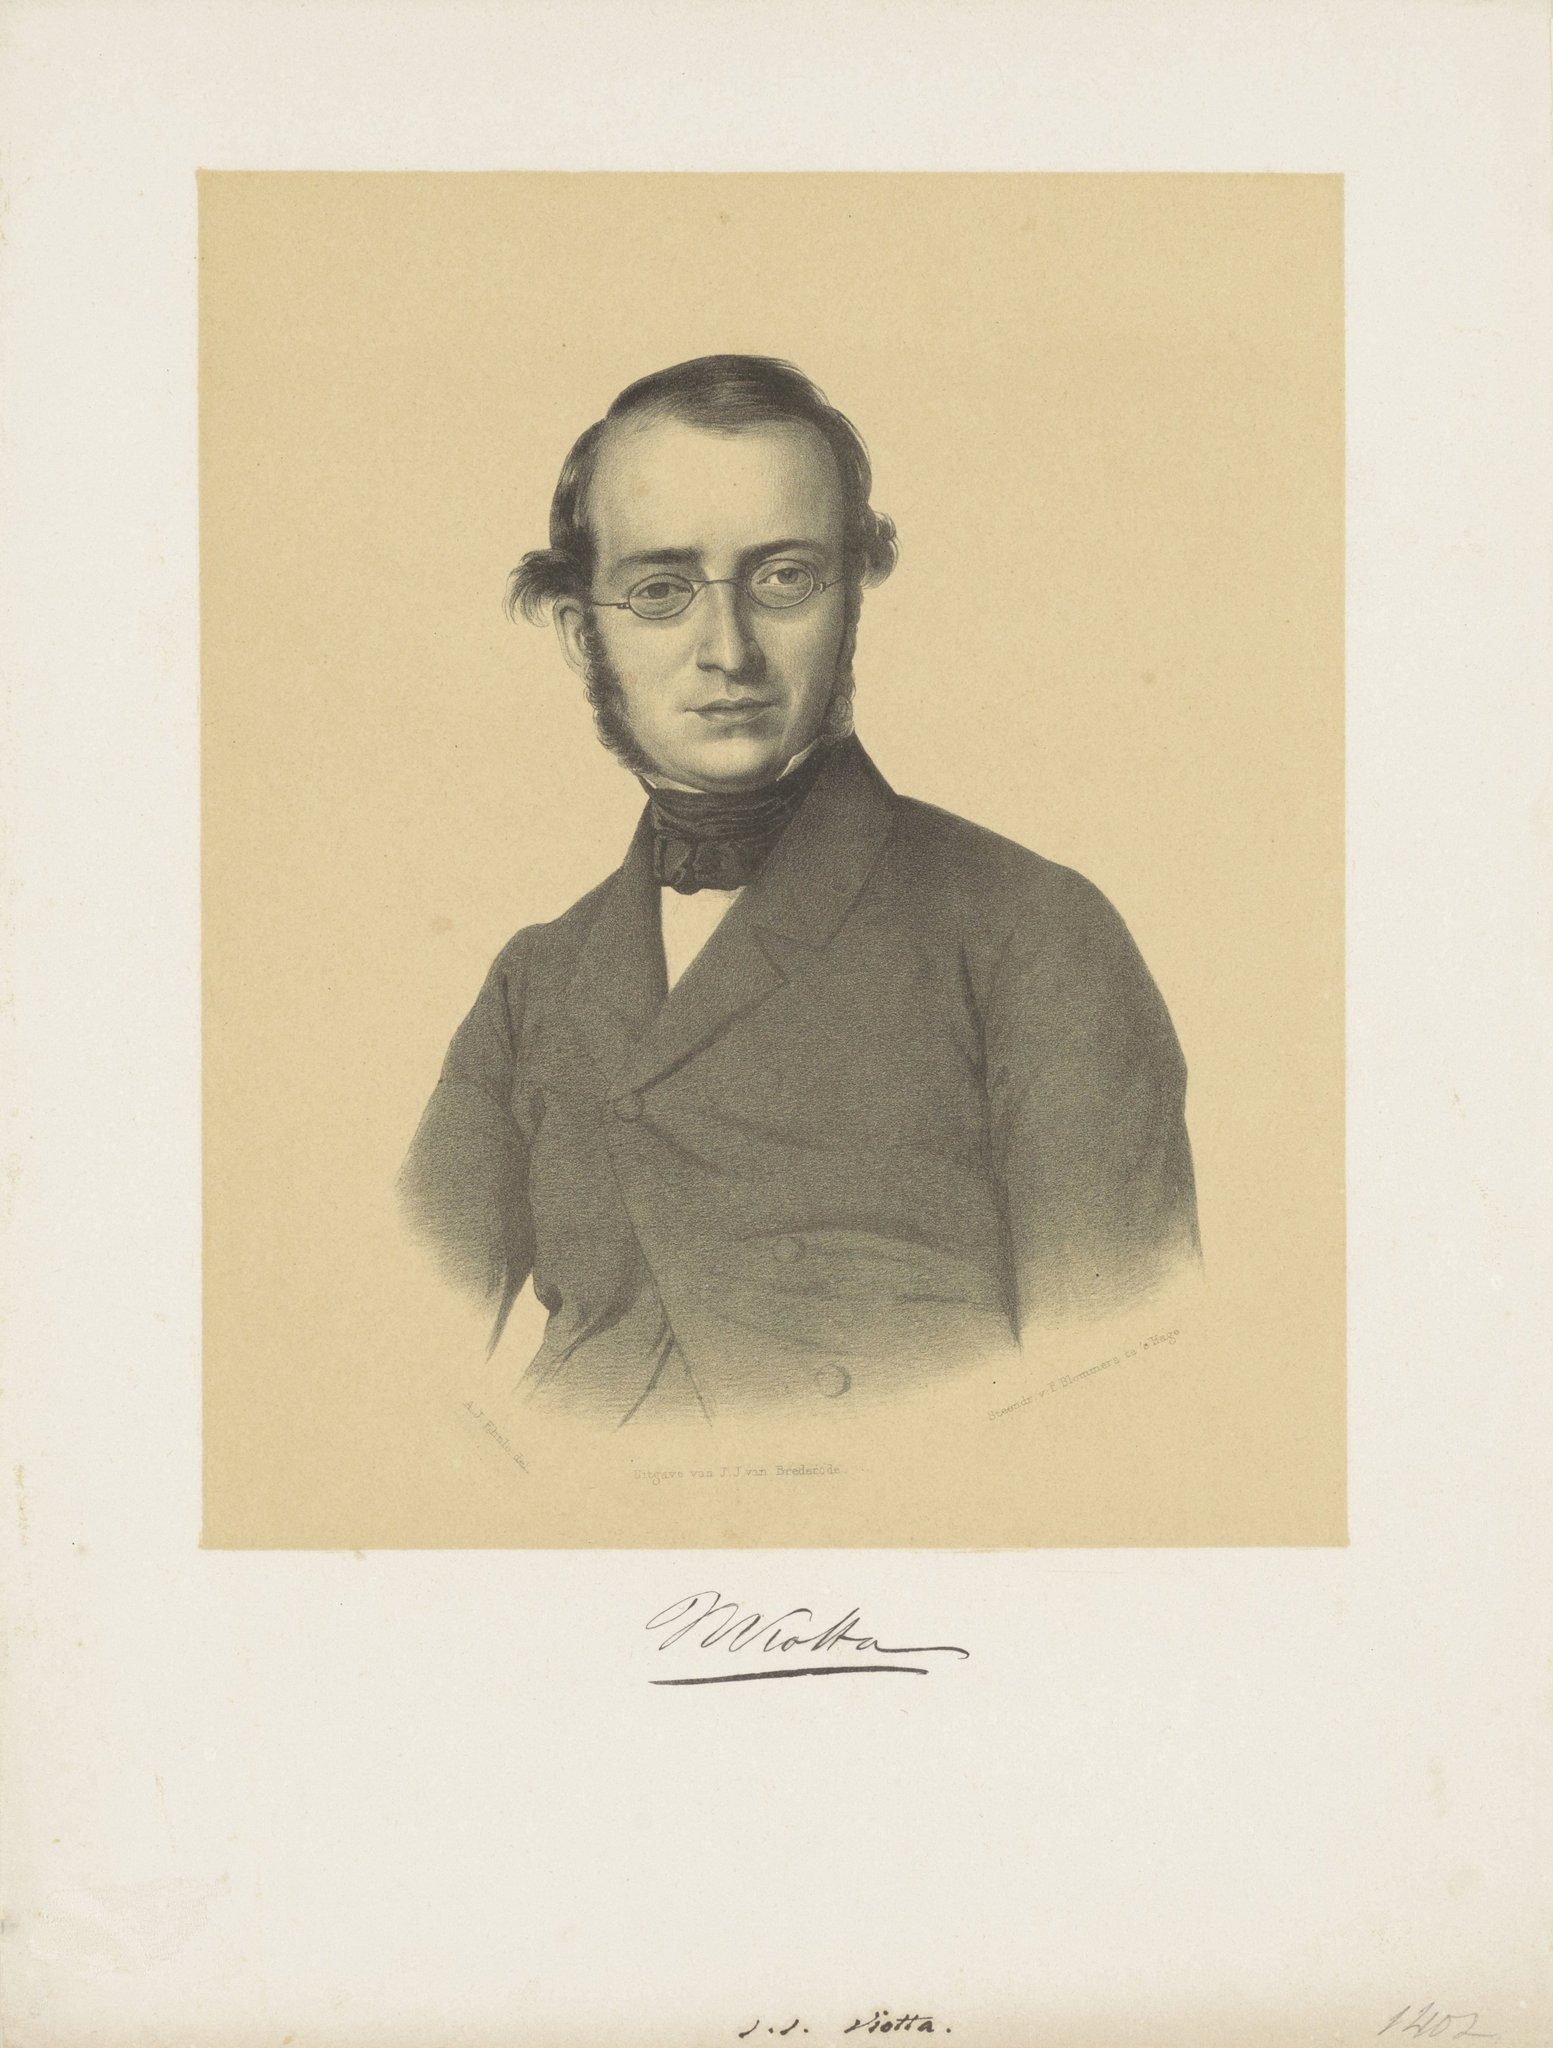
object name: print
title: Portret van Joannes Josephus Viotta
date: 1847-1887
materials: paper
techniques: tone lithography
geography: haarlem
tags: eyeglasses, spectacles, historical persons (+ (full) bust portrait)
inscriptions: collector's mark: Lugt 2228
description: De geportretteerde draagt een bril. Onder het portret zijn signatuur.